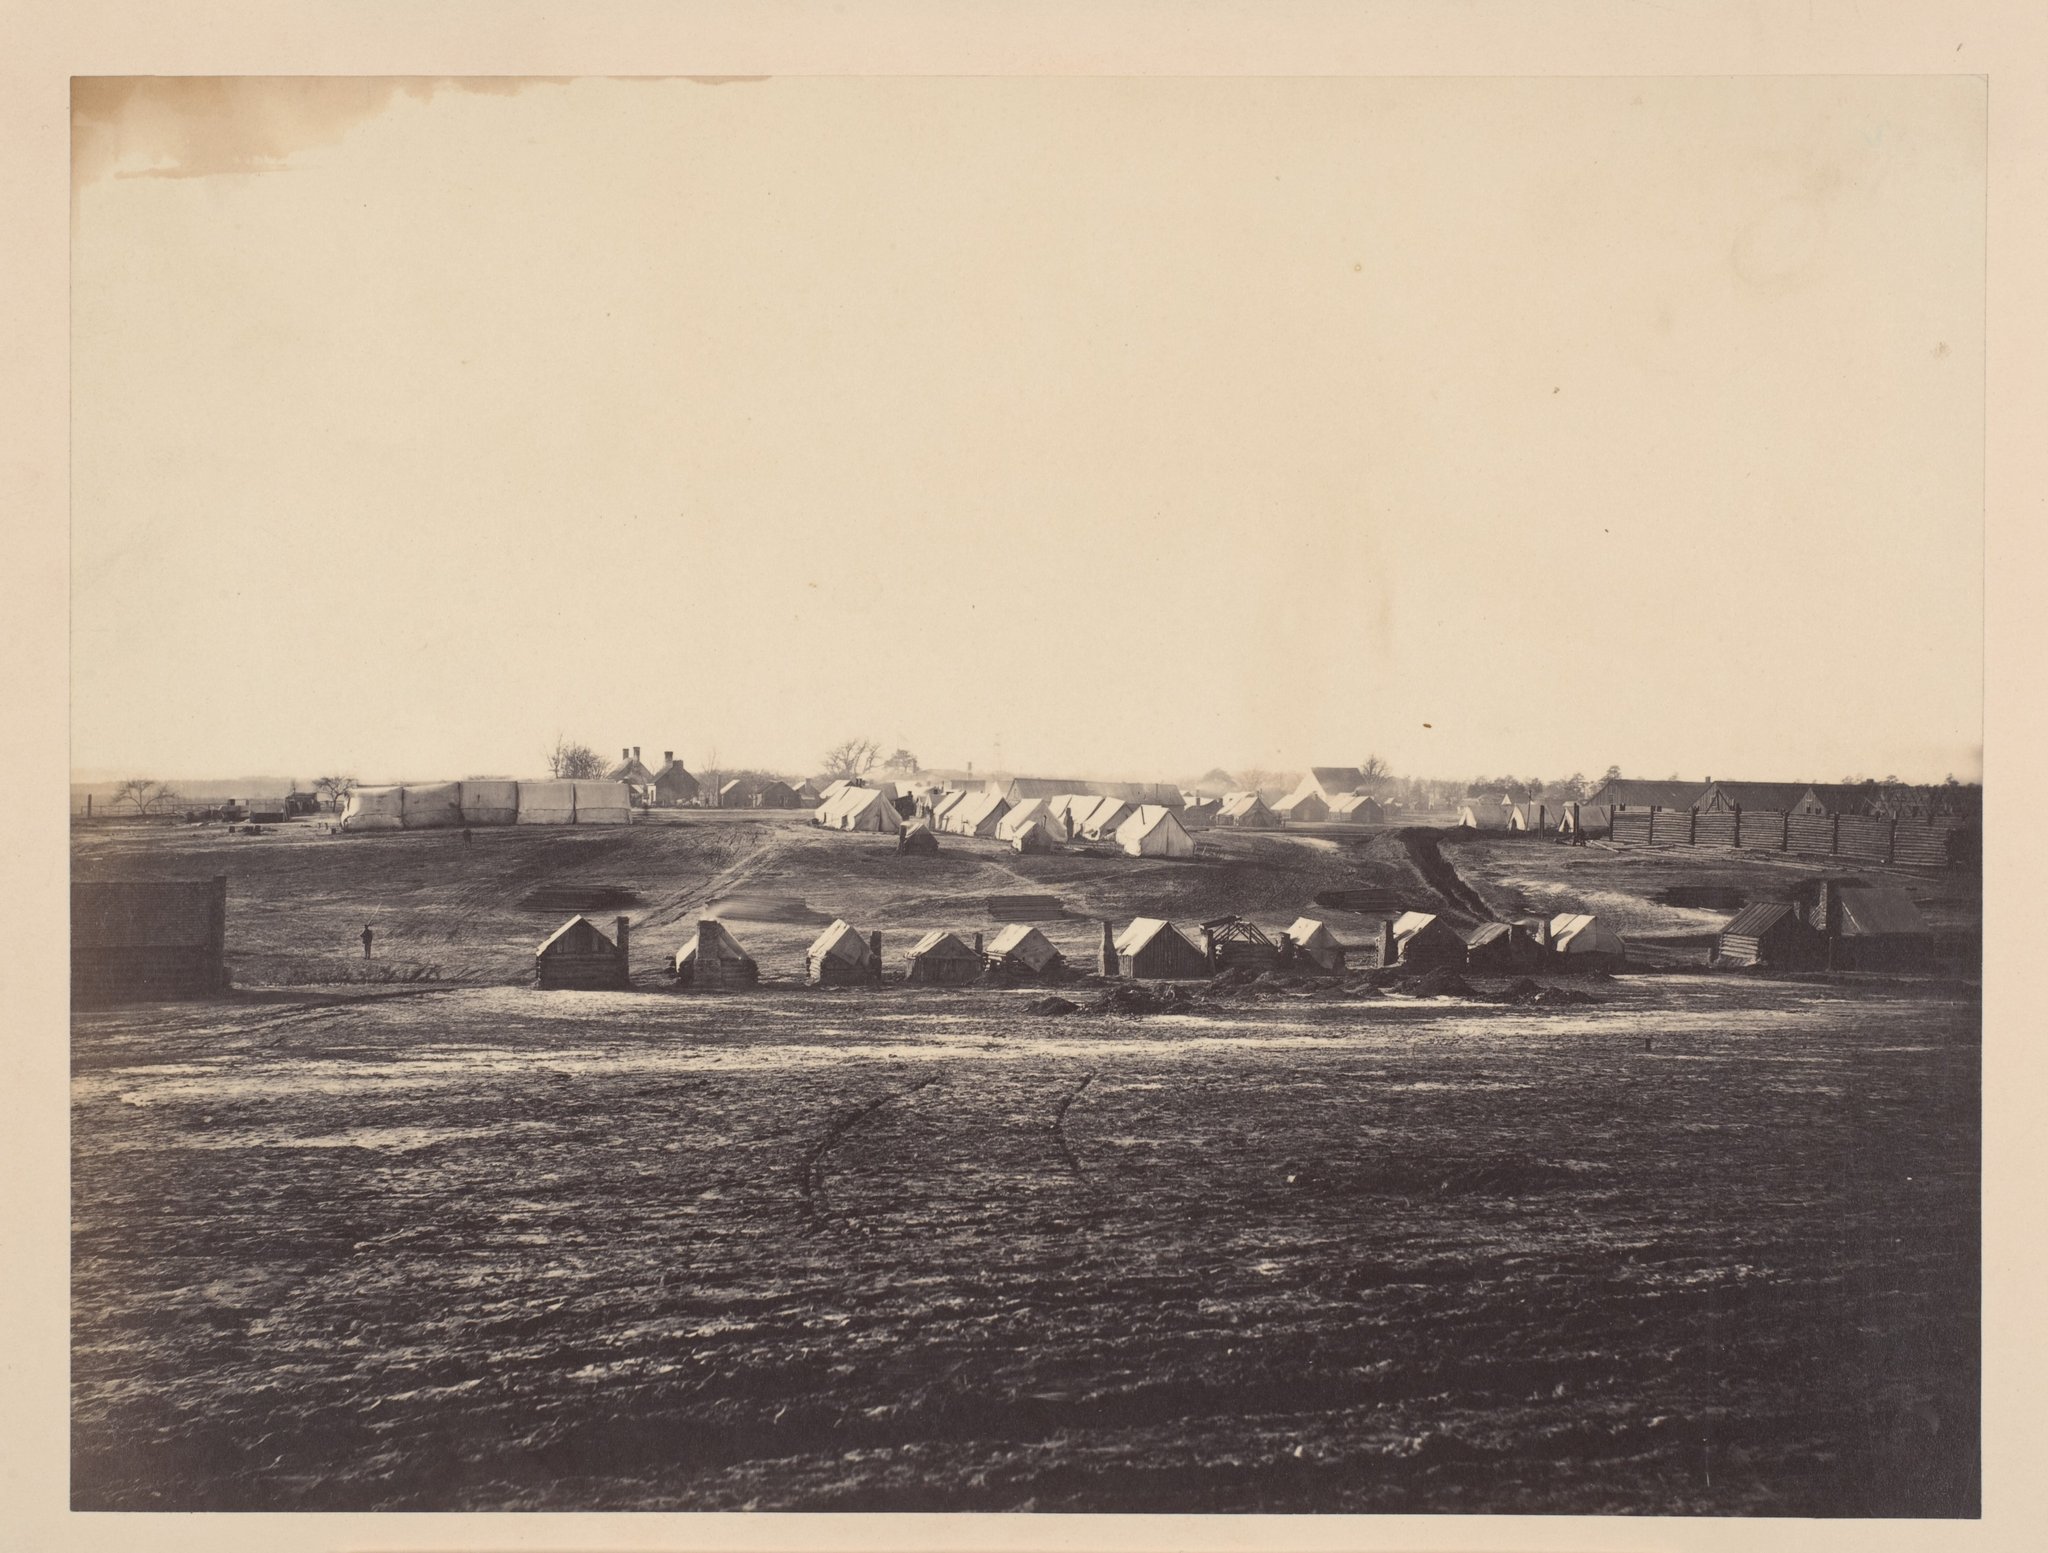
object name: photograph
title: [Civil War View]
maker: thomas c. roche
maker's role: artist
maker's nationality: american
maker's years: 1826-1895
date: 1860-1869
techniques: albumen silver print, glass negative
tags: tents,american civil war,landscapes